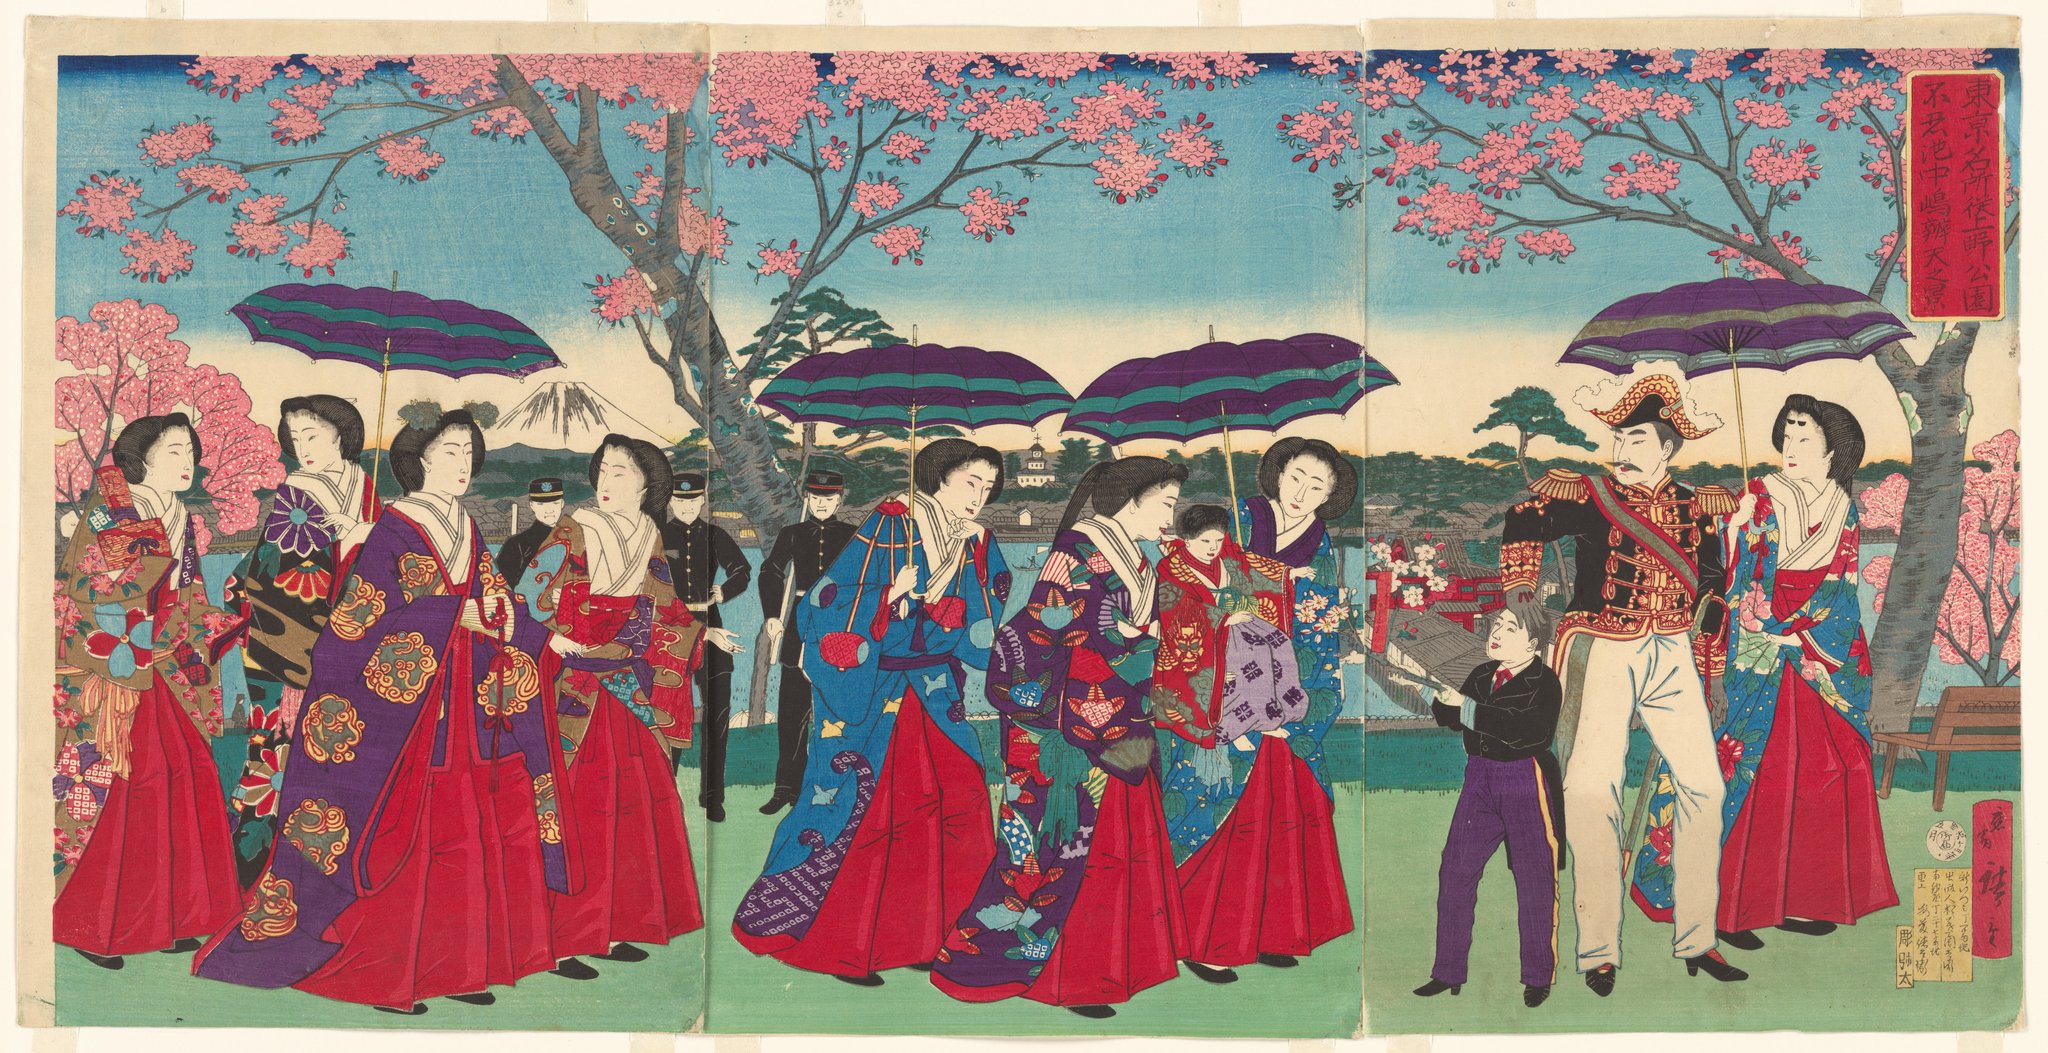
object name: print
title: View of Benten Shrine on Nakanoshima Island in Shinobazu Pond, Ueno Park, from the series Famous Views of Tokyo (Tōkyō Tokyo meisho yori Ueno kōen Shinobazu no ike Nakanoshima Benten no kei)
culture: japanese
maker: utagawa hiroshige iii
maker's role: artist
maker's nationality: japanese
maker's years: 1843-1894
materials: ink, paper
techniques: nishiki e, woodblock print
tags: parks,children,men,women,trees,parasols